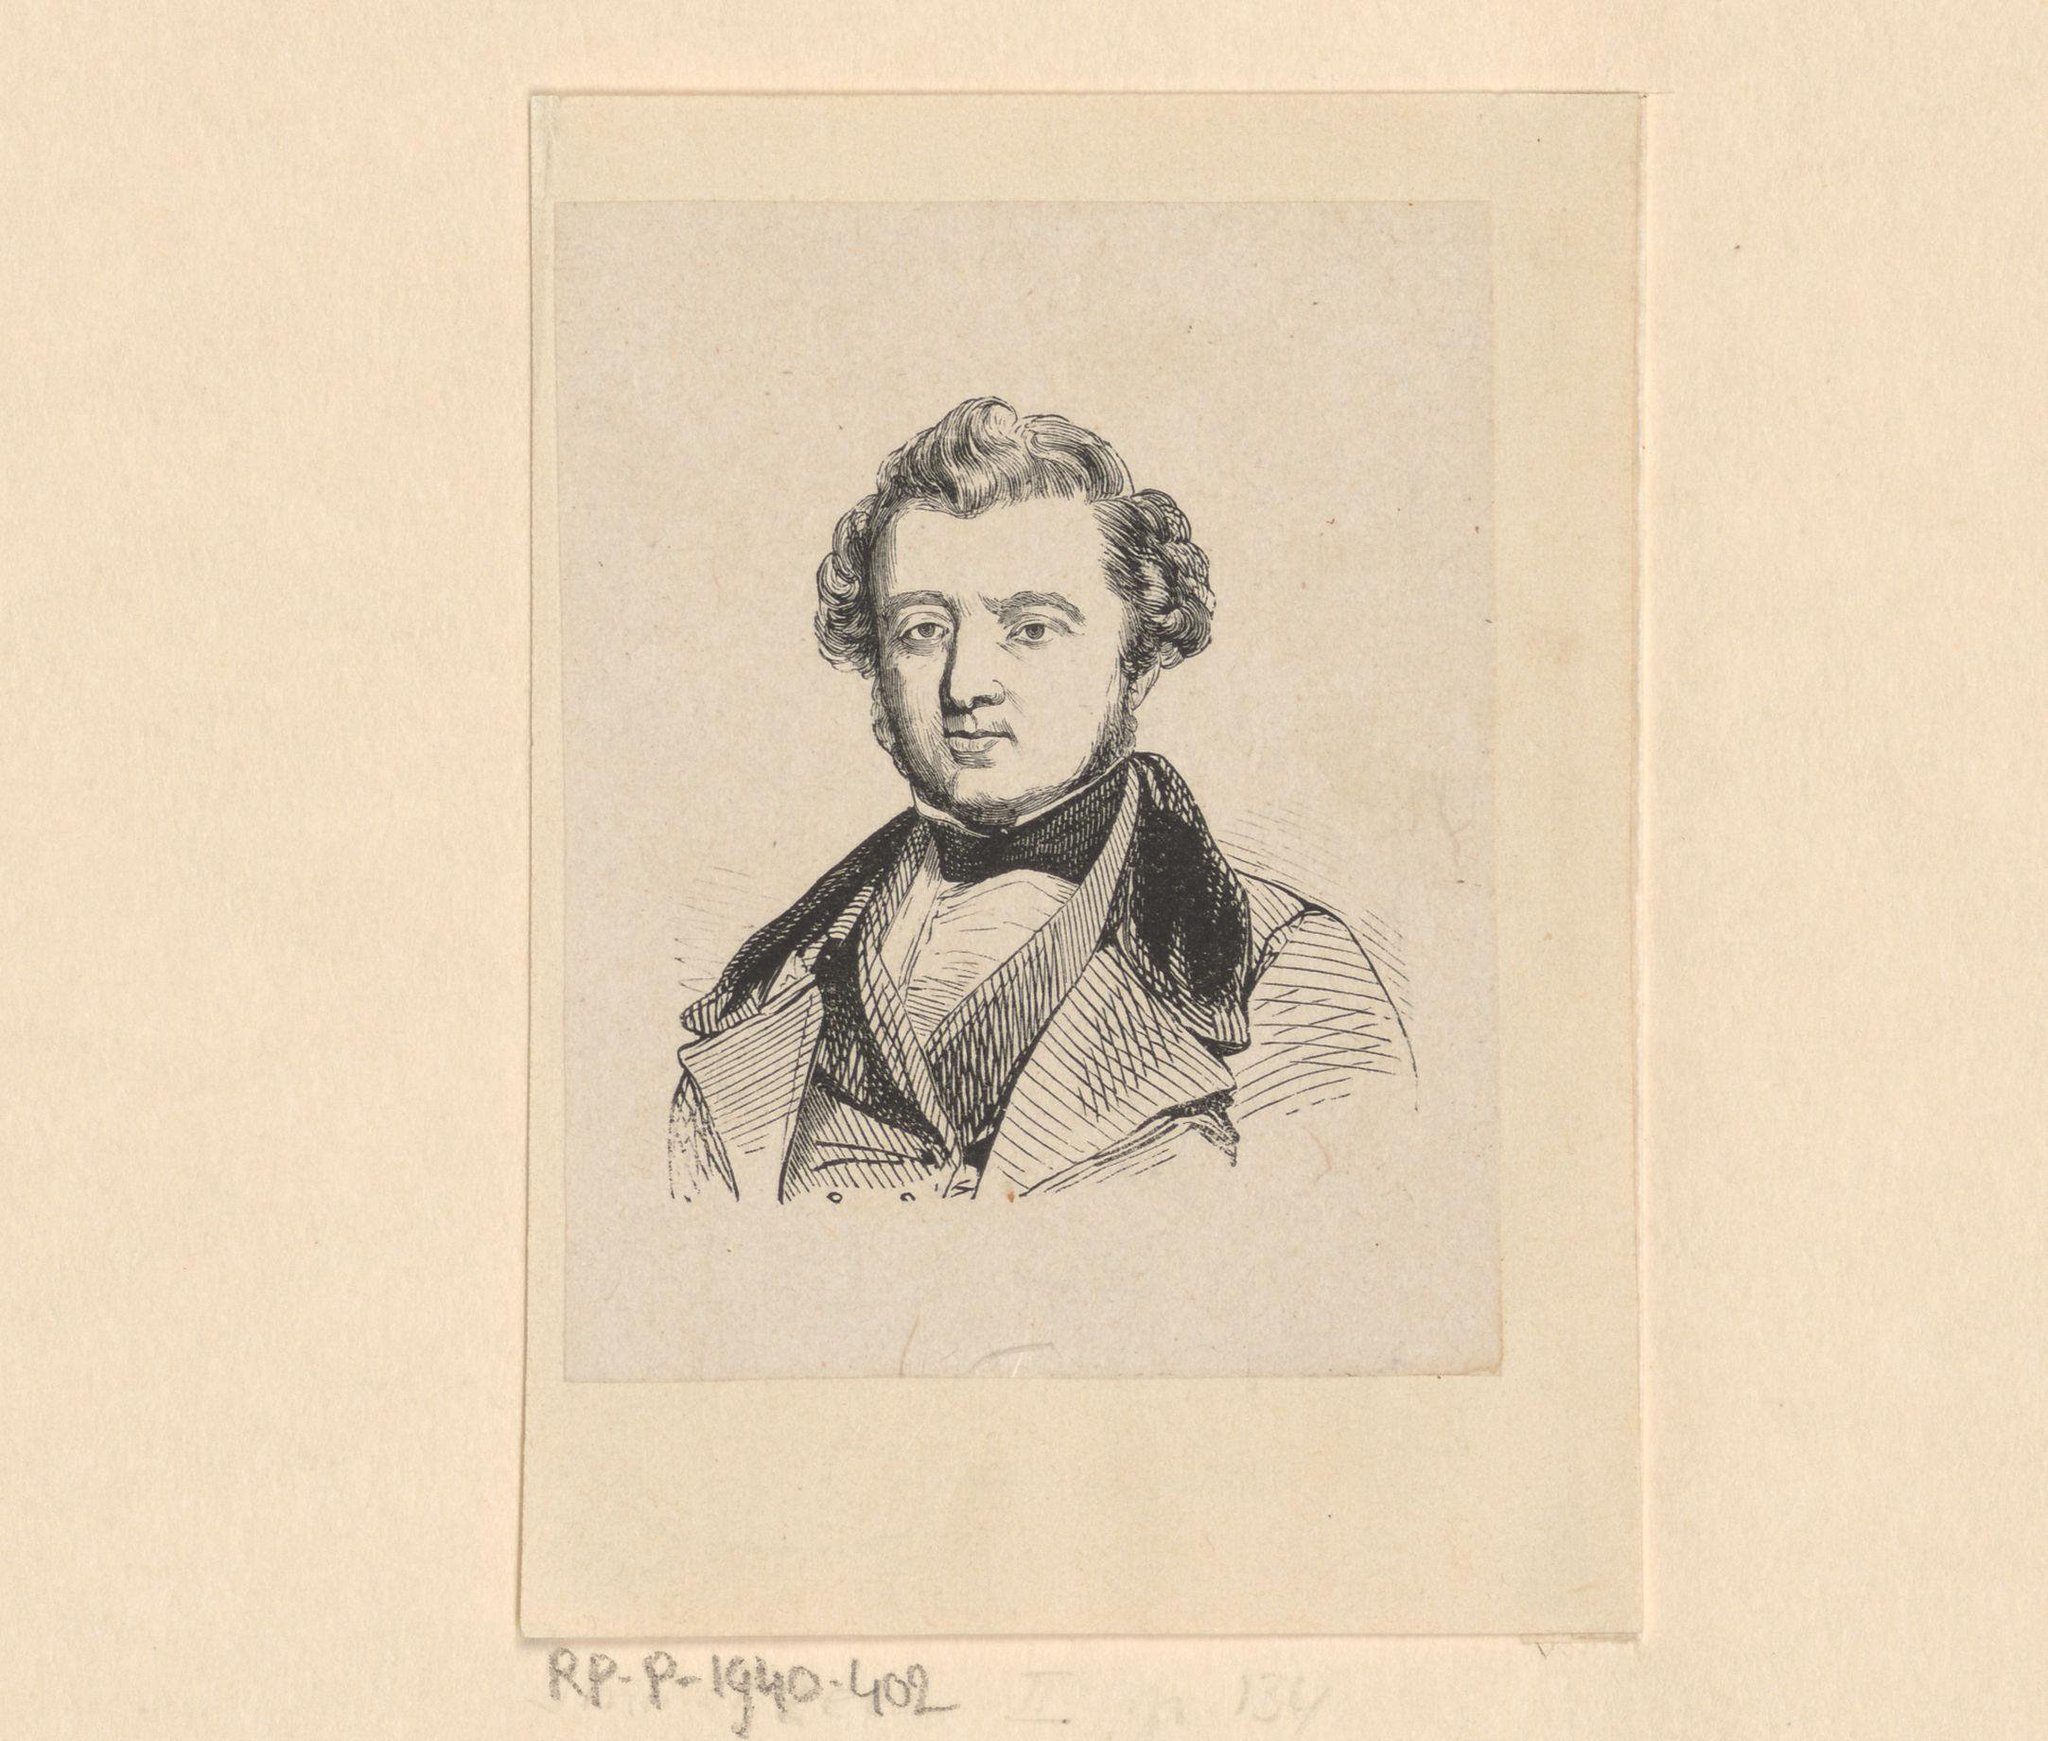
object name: print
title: Portret van Christiaan Kramm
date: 1843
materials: paper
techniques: engraving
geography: amsterdam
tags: utrecht, christiaan kramm, historical persons, portrait, self-portrait of painter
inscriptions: collector's mark: Lugt 2760, collector's mark: Lugt 2228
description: Prent uit: Immerzeel, Johannes. De levens en werken der Hollandsche en Vlaamsche kunstschilders. Amsterdam: Johannes Christoffel van Kesteren, 1843, dl. 2, p. 134.